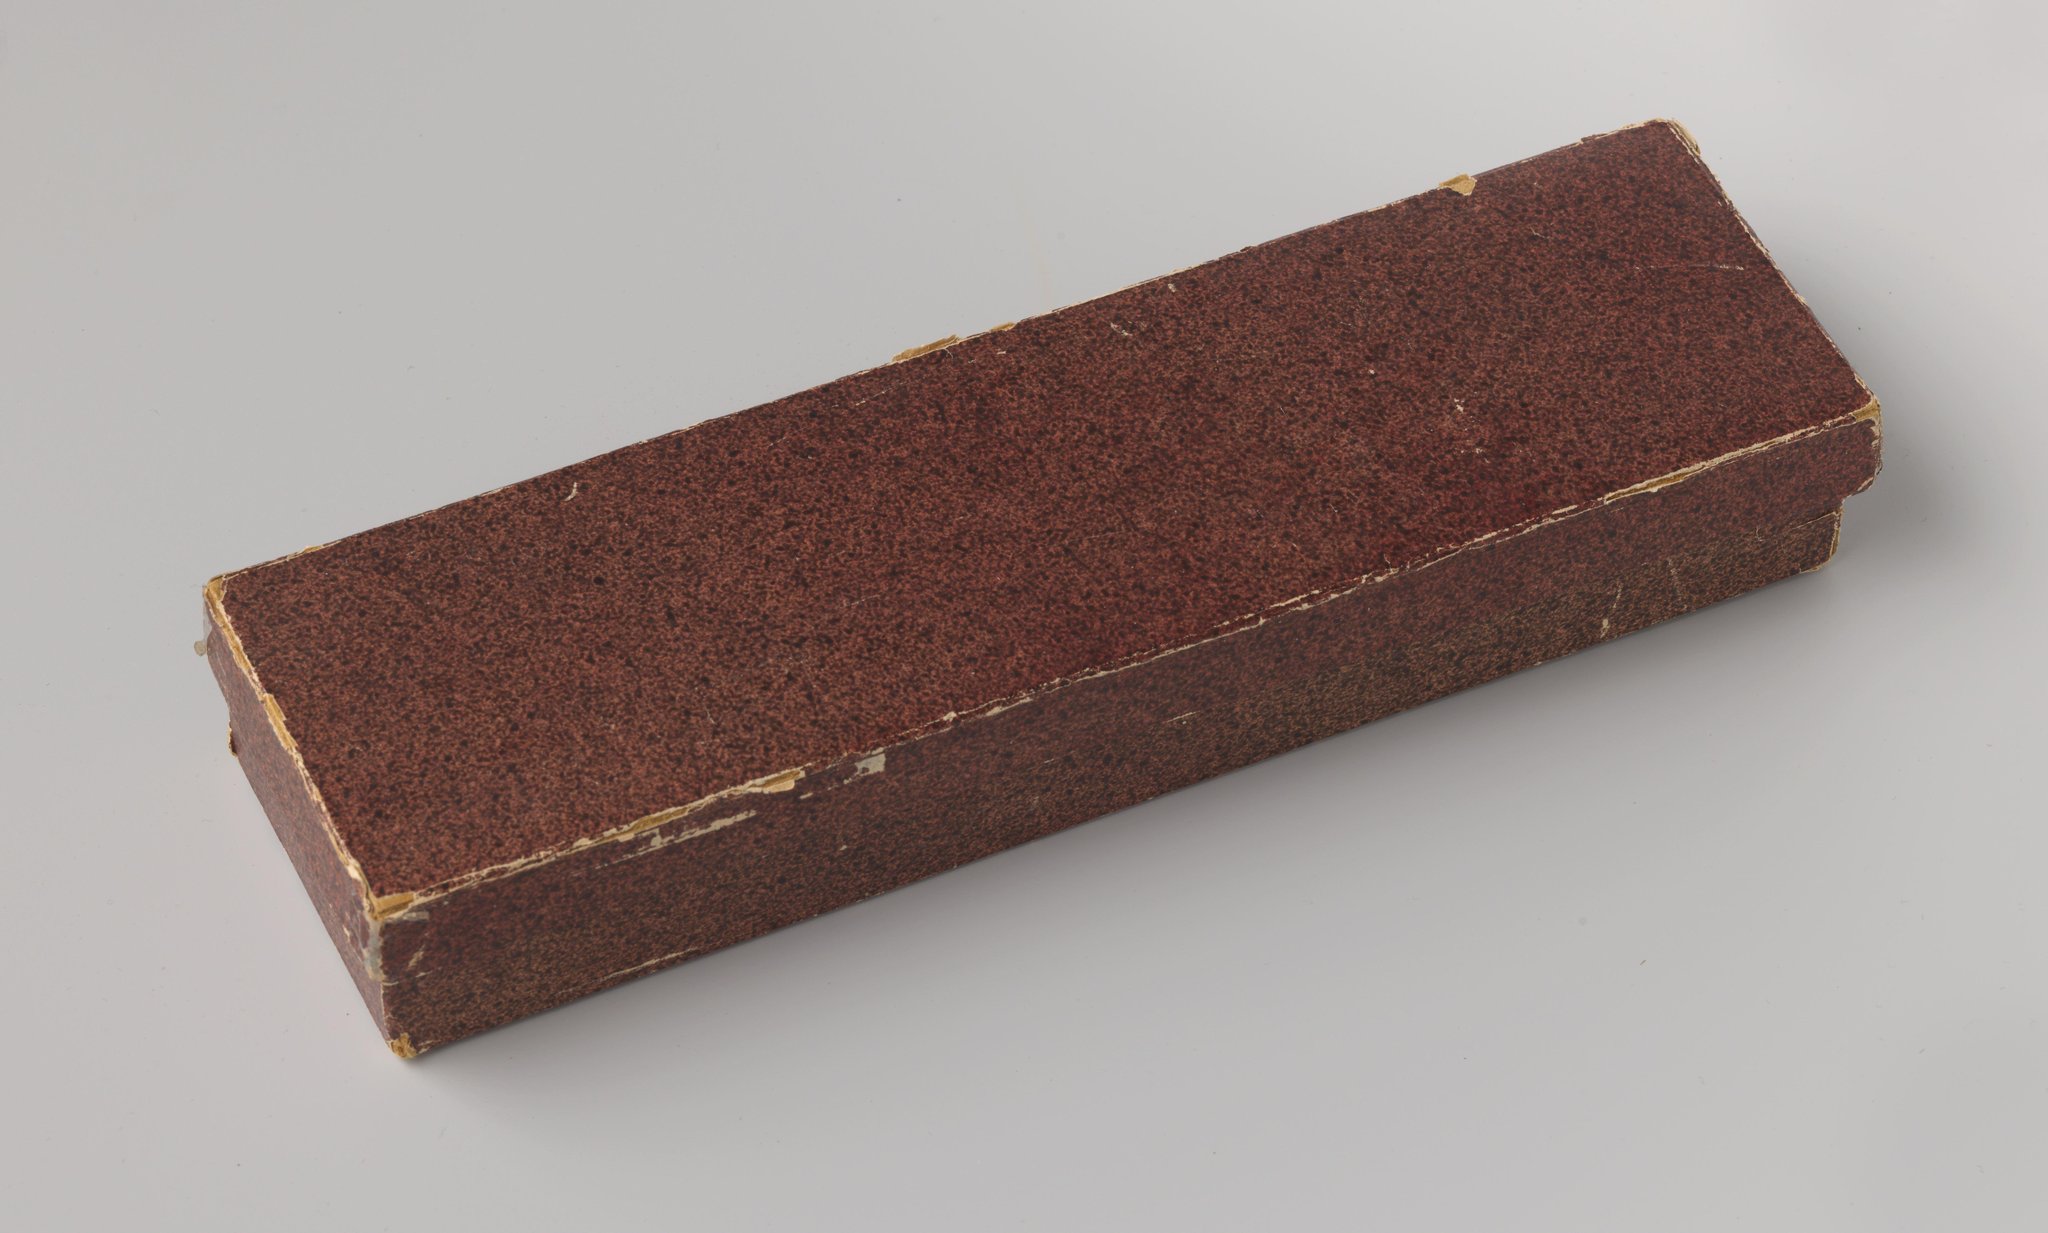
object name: menswear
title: Doosje van aubergine en zwart gevlekt papier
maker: Anonymous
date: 1885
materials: paper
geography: amsterdam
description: Doosje van aubergine en zwart gevlekt papier. Notitie in doosje: "W. Six 1859-1928/1885". Het doosje bevat een oranje sjerp (a).